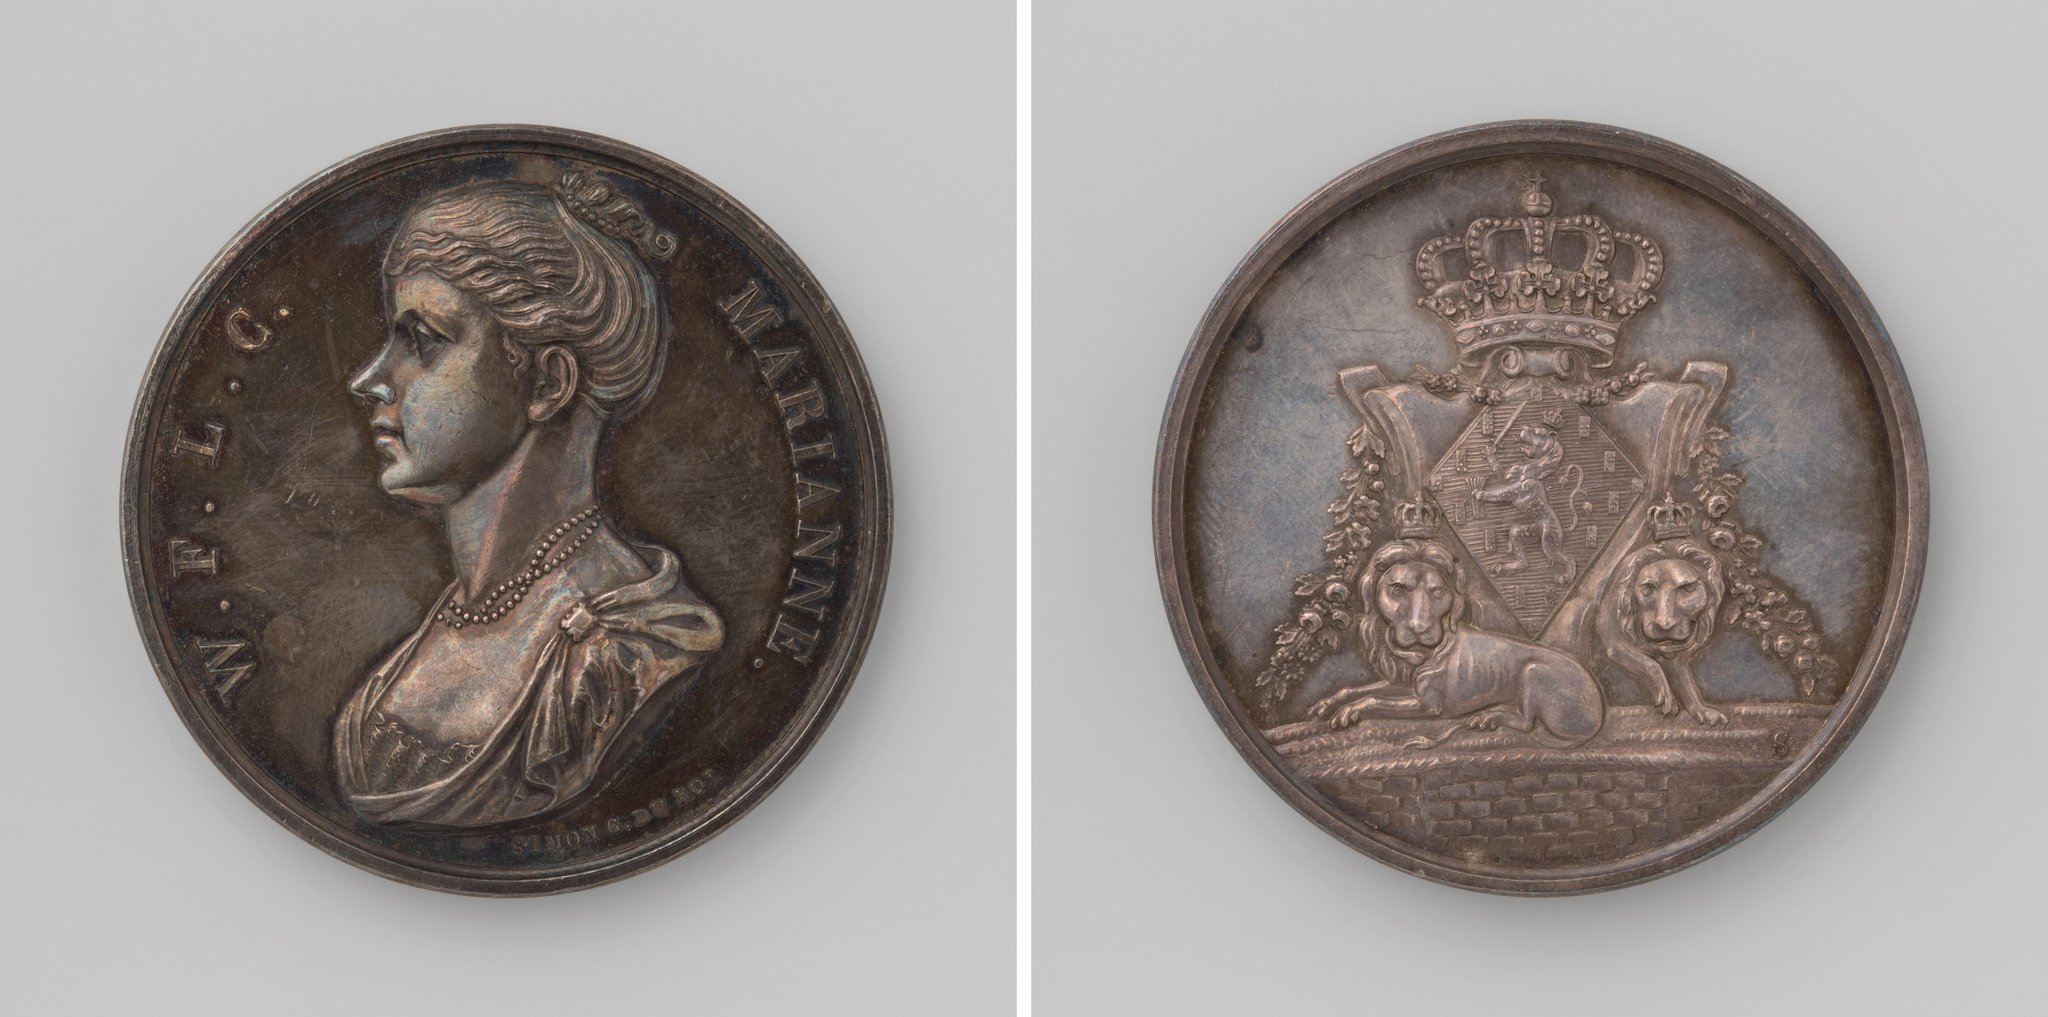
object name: history medal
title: Marianne, prinses van Oranje-Nassau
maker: jean henri simon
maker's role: medailleur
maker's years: 1752-1834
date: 1845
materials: silver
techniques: striking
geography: brussels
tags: berlin, voorburg, marianne (prinses der nederlanden)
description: Zilveren penning. Voorzijde: borststuk vrouw binnen omschrift. Keerzijde: gekroond wapenschild, omhangenmet bloemenguirlande, waarvoor een leeuw ligt, en waar ander leeuw achter vandaankruipt